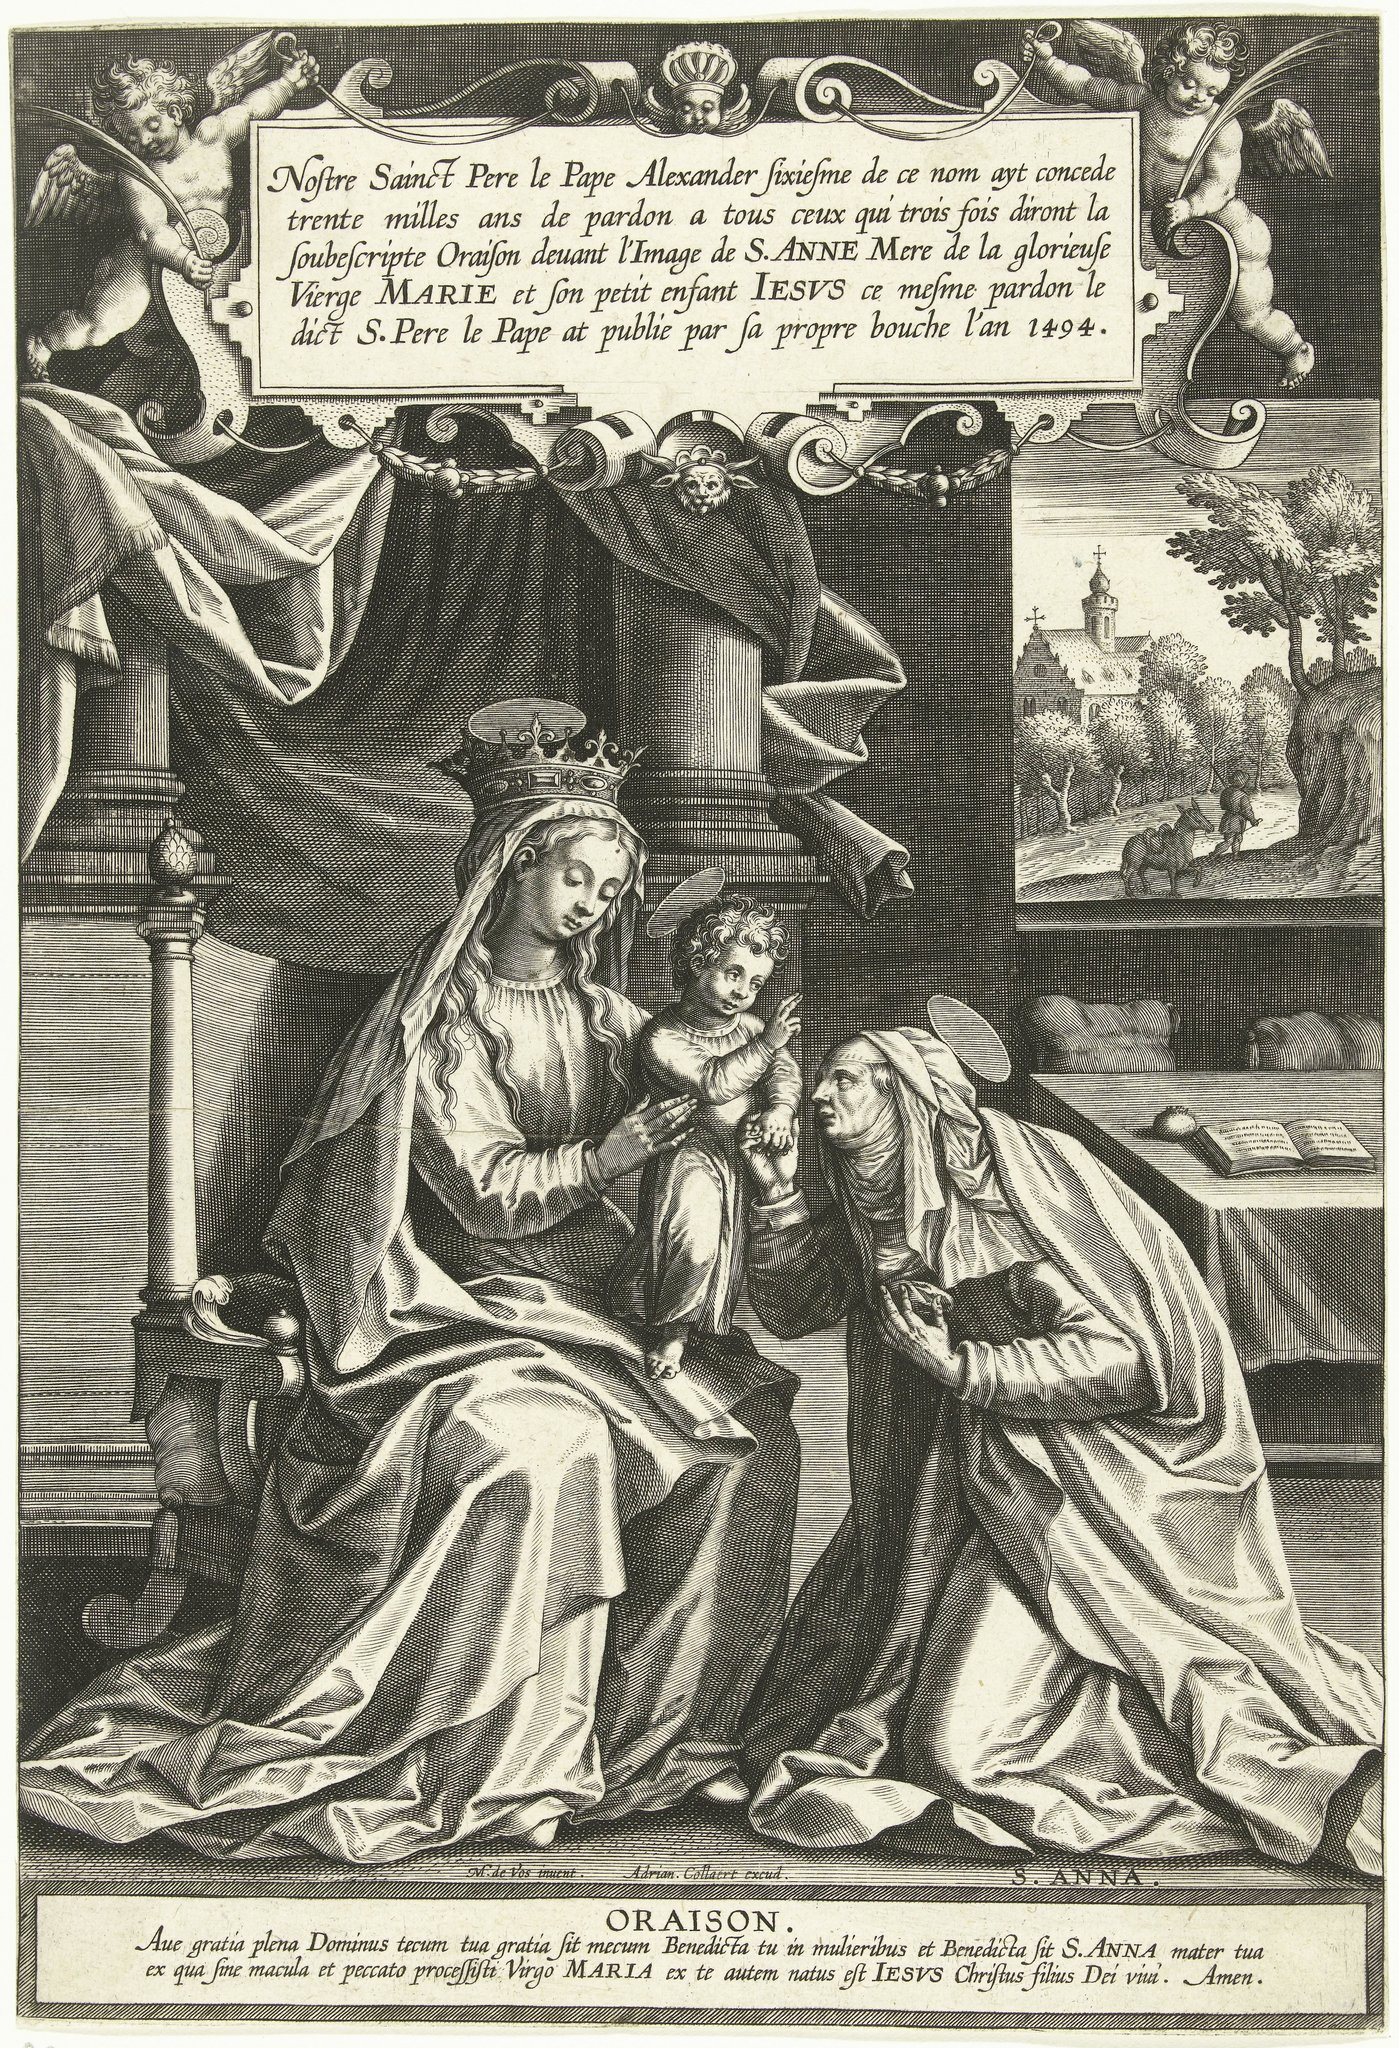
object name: print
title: Anna te Drieën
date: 1570-1618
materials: paper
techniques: engraving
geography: antwerp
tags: 'anna selbdritt', i.e. anna, mary and christ-child close together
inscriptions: collector's mark: Lugt 2228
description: Een kamerinterier waar Christus op de schoot van Maria zijn grootmoeder Anna zegent. Gezicht op een landschap met een kerk door uit venster. De prent heeft een Frans opschrift in cartouche en een Latijns onderschrift.